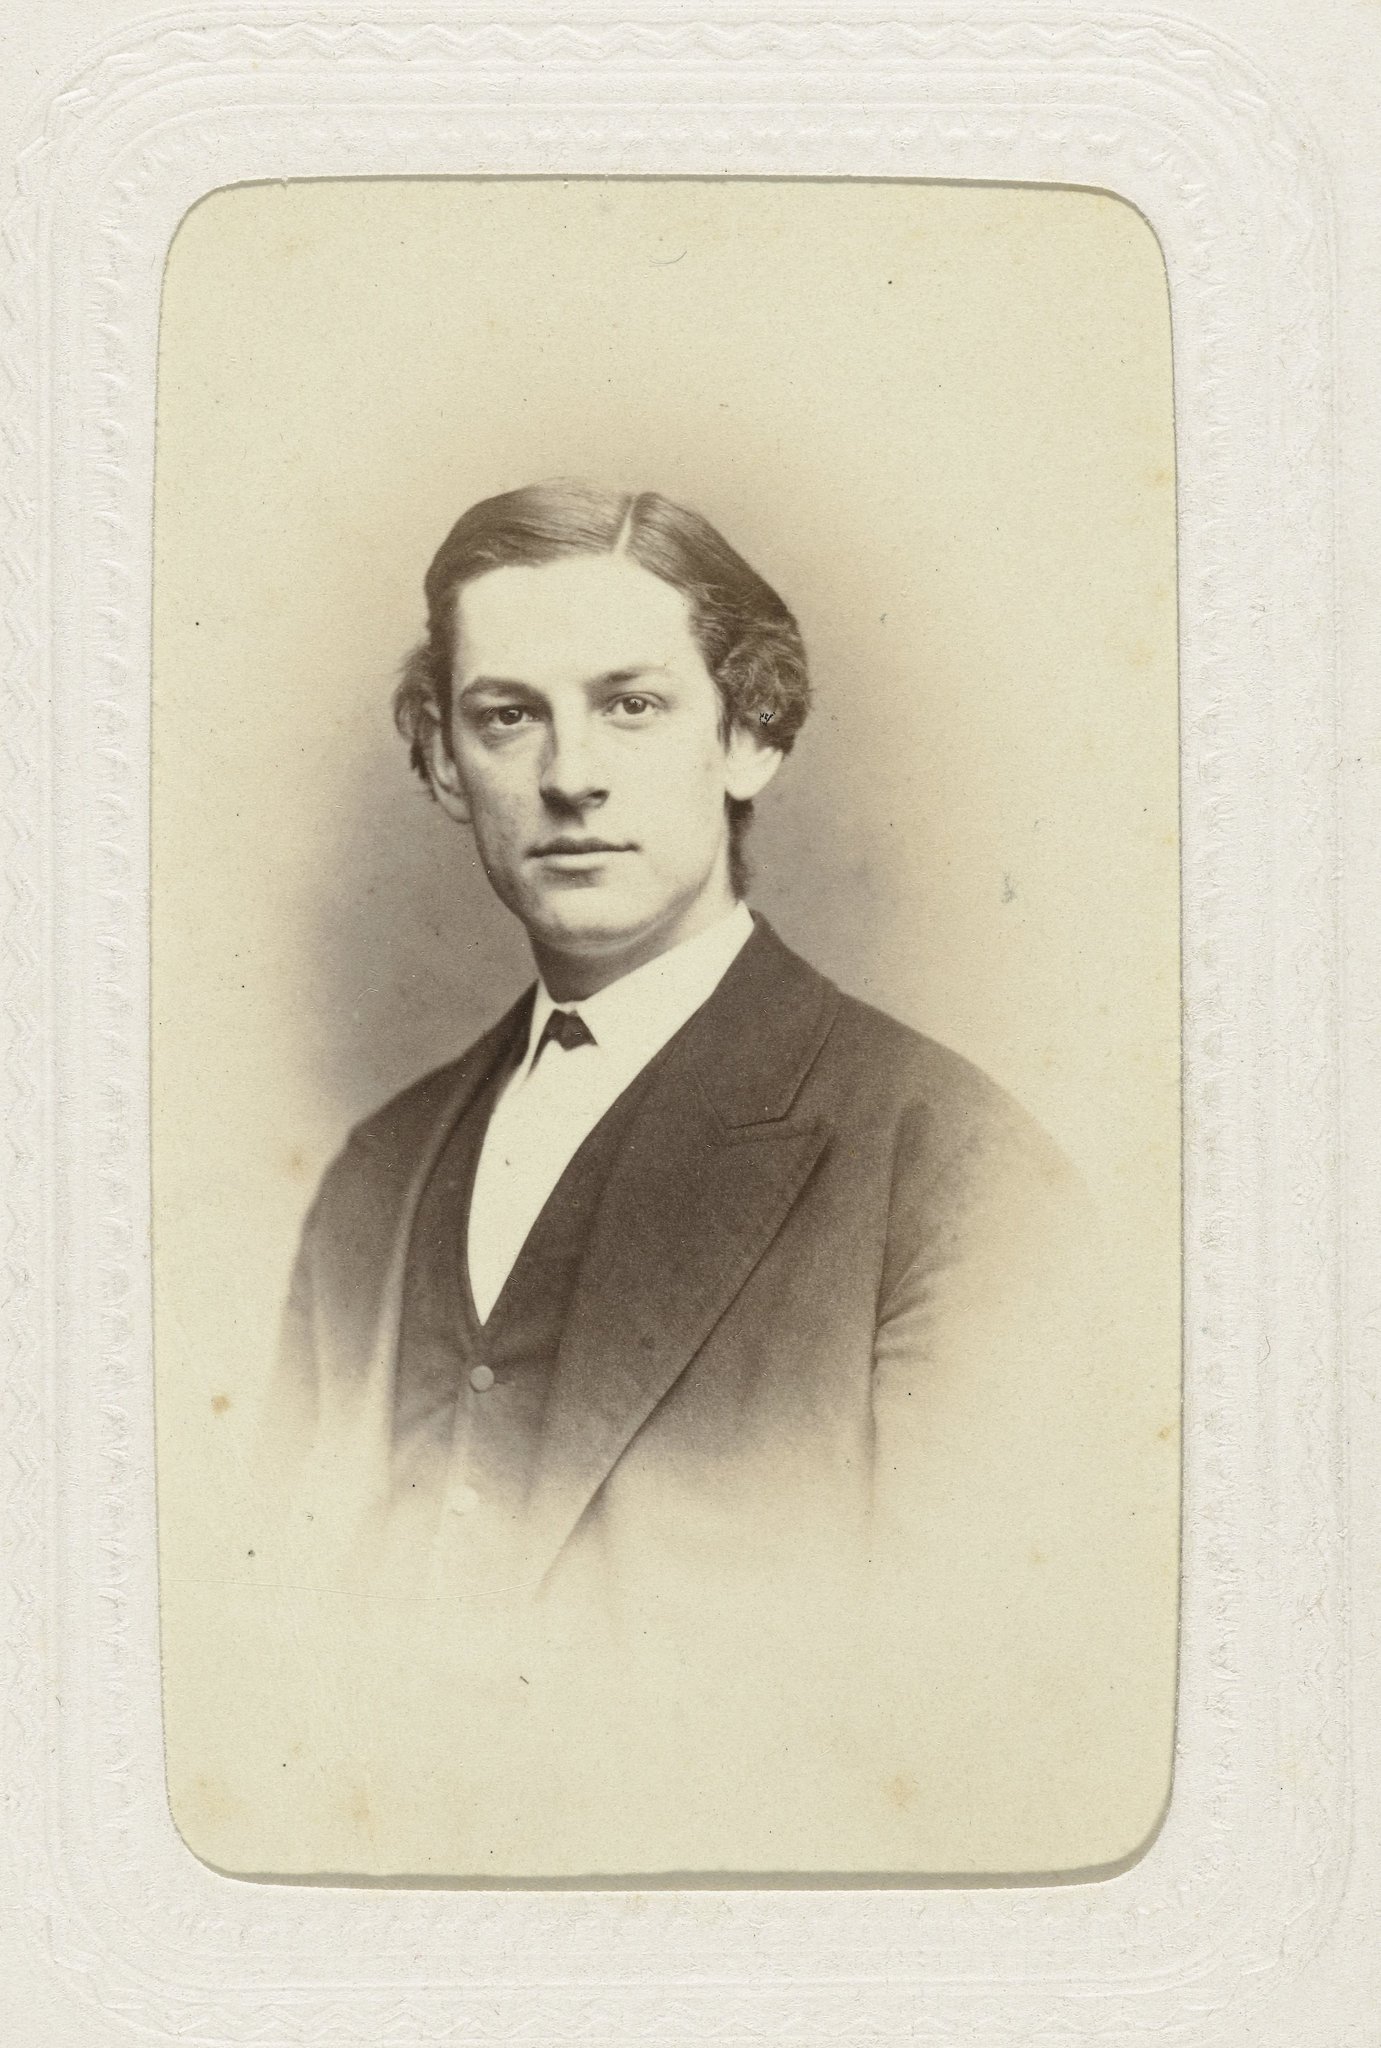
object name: carte de visite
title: Studioportret van een jongeman met een scheiding in zijn haar.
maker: g. reussing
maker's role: print maker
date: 1863-1870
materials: cardboard, paper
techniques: albumen print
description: De man op de foto is dezelfde als op rp-f-00-5360-8 en rp-f-00-5360-9